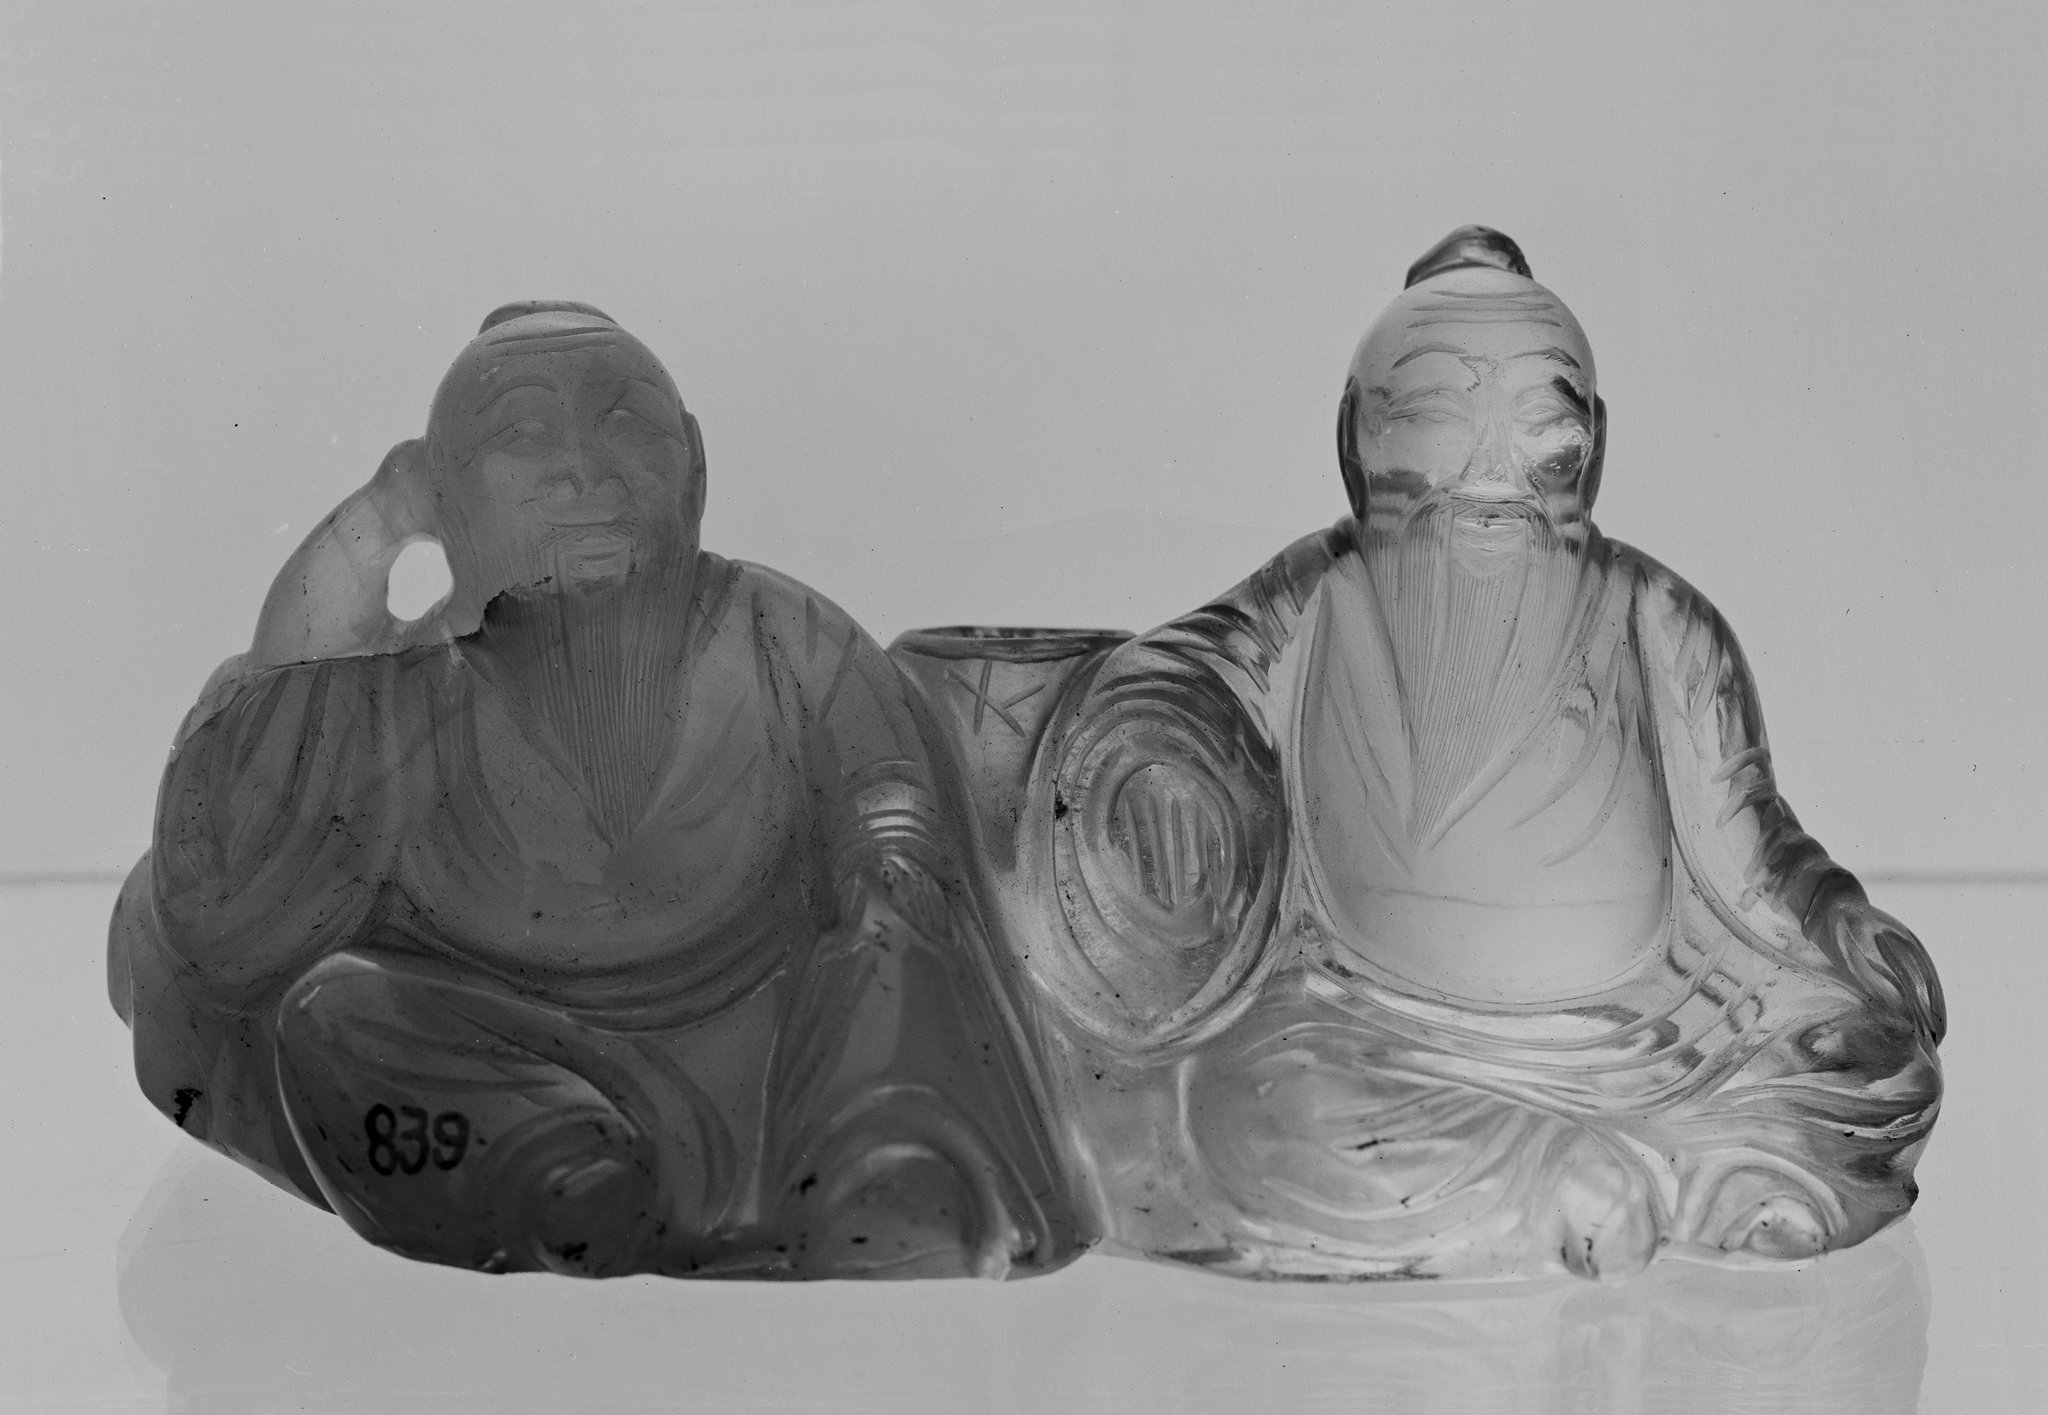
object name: group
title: Group of Two Seated Figures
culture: chinese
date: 1701-1800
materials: quartz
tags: men